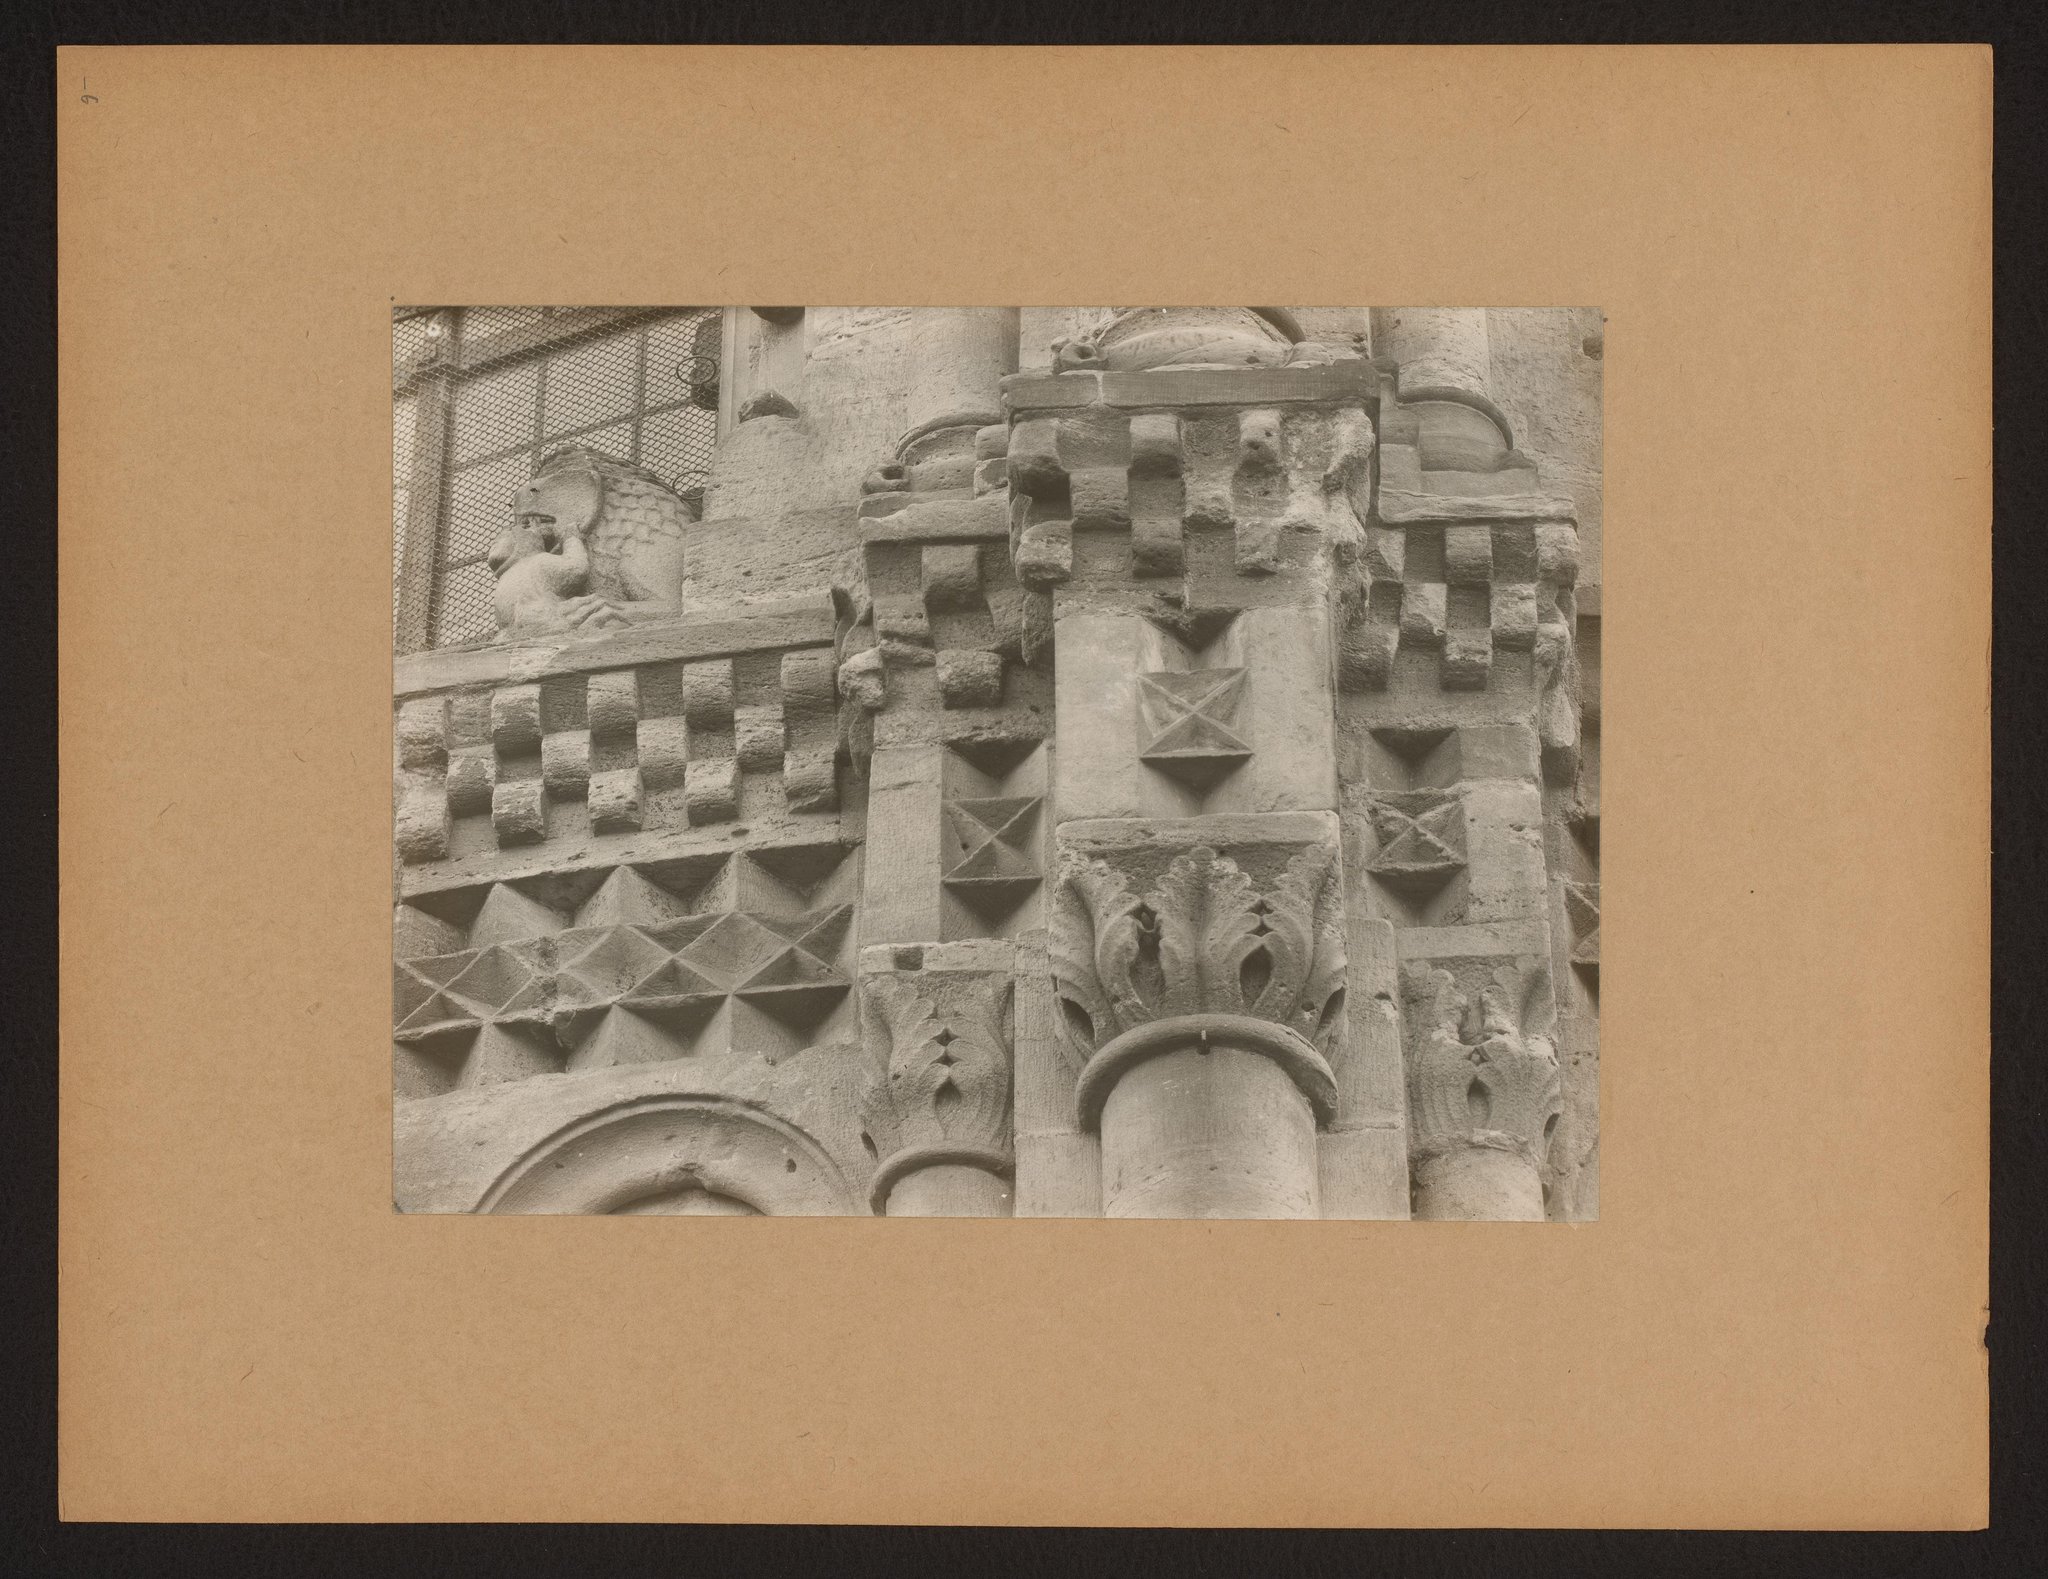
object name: album leaf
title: Gezicht op het beeldhouwwerk van een fries van de dom van Bamberg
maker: Anonymous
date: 1900-1920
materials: paper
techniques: gelatin silver print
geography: bamberg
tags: church (exterior)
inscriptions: number: ‘6.’